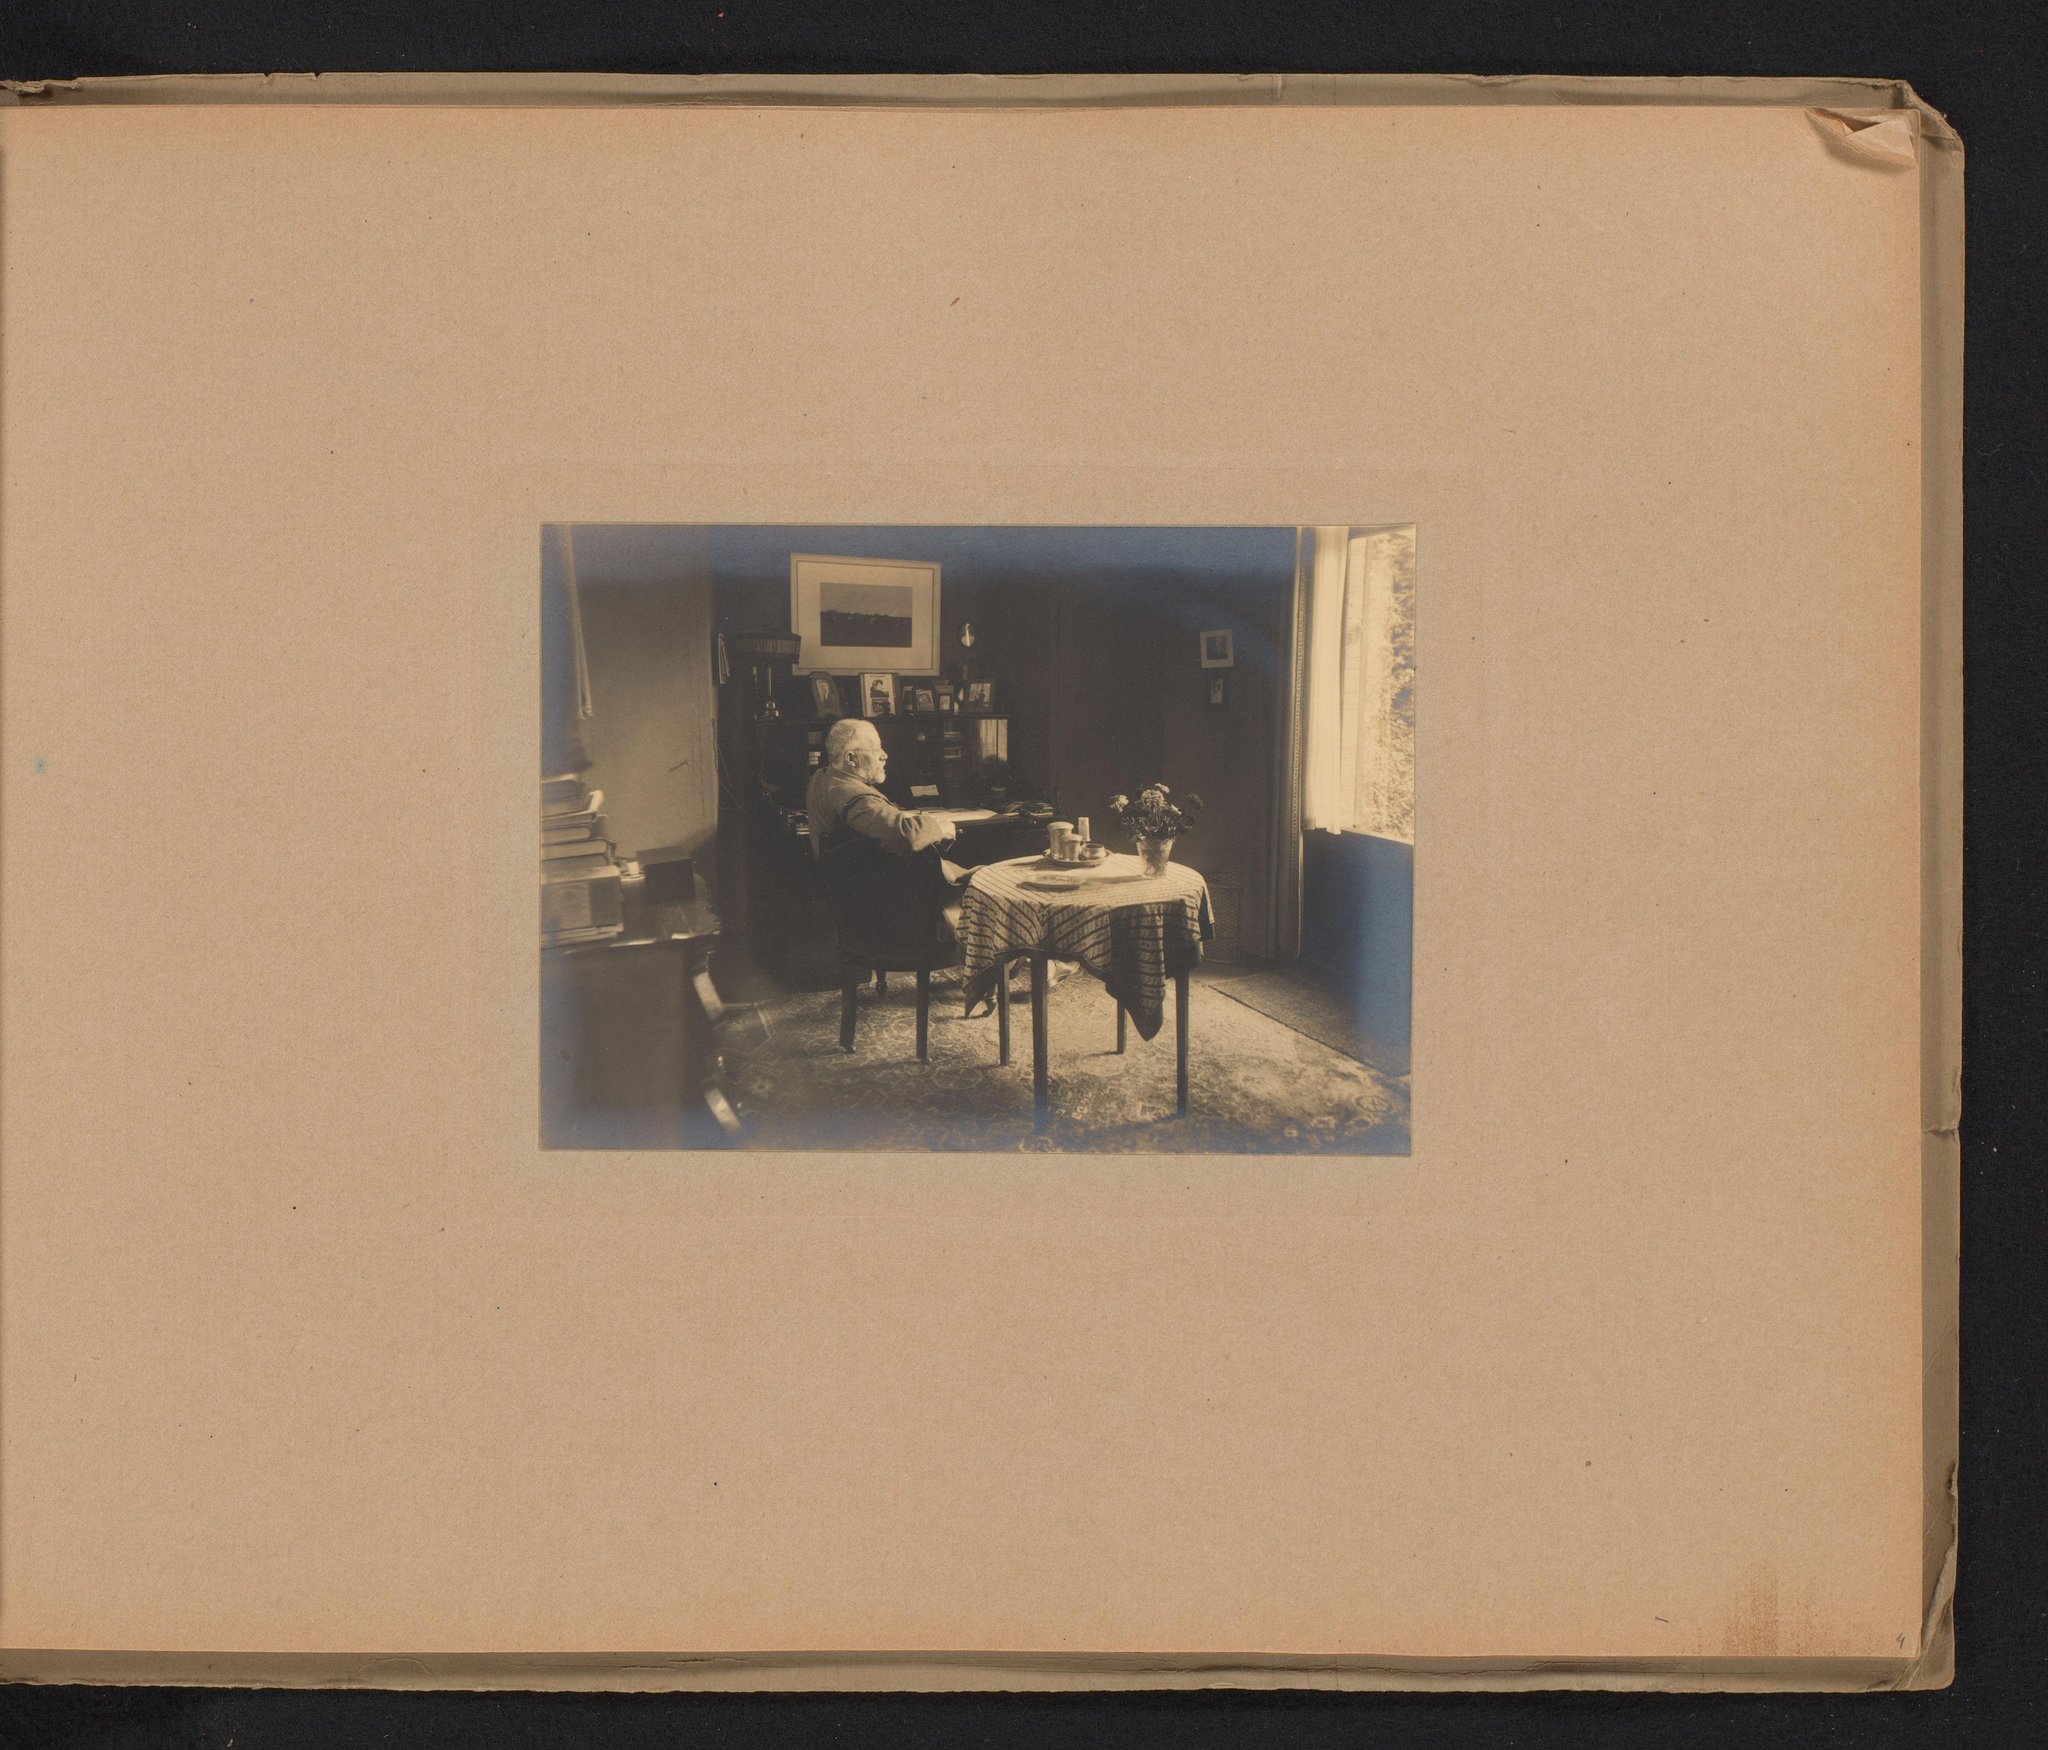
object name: photograph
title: Lucas Jonker zittend aan zijn bureau te Bussum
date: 1890-1915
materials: paper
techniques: gelatin silver print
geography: bussum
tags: writing-table, writing-desk, historical persons